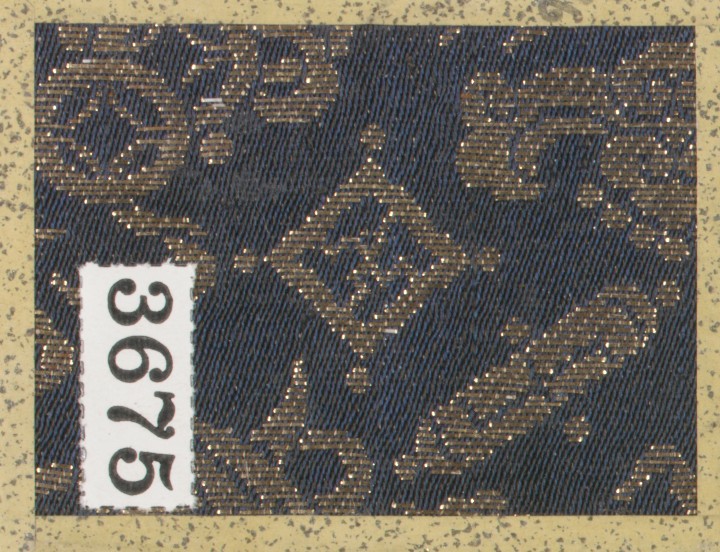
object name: sample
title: Textile Sample from Sample Book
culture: japanese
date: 1801-1900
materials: silk